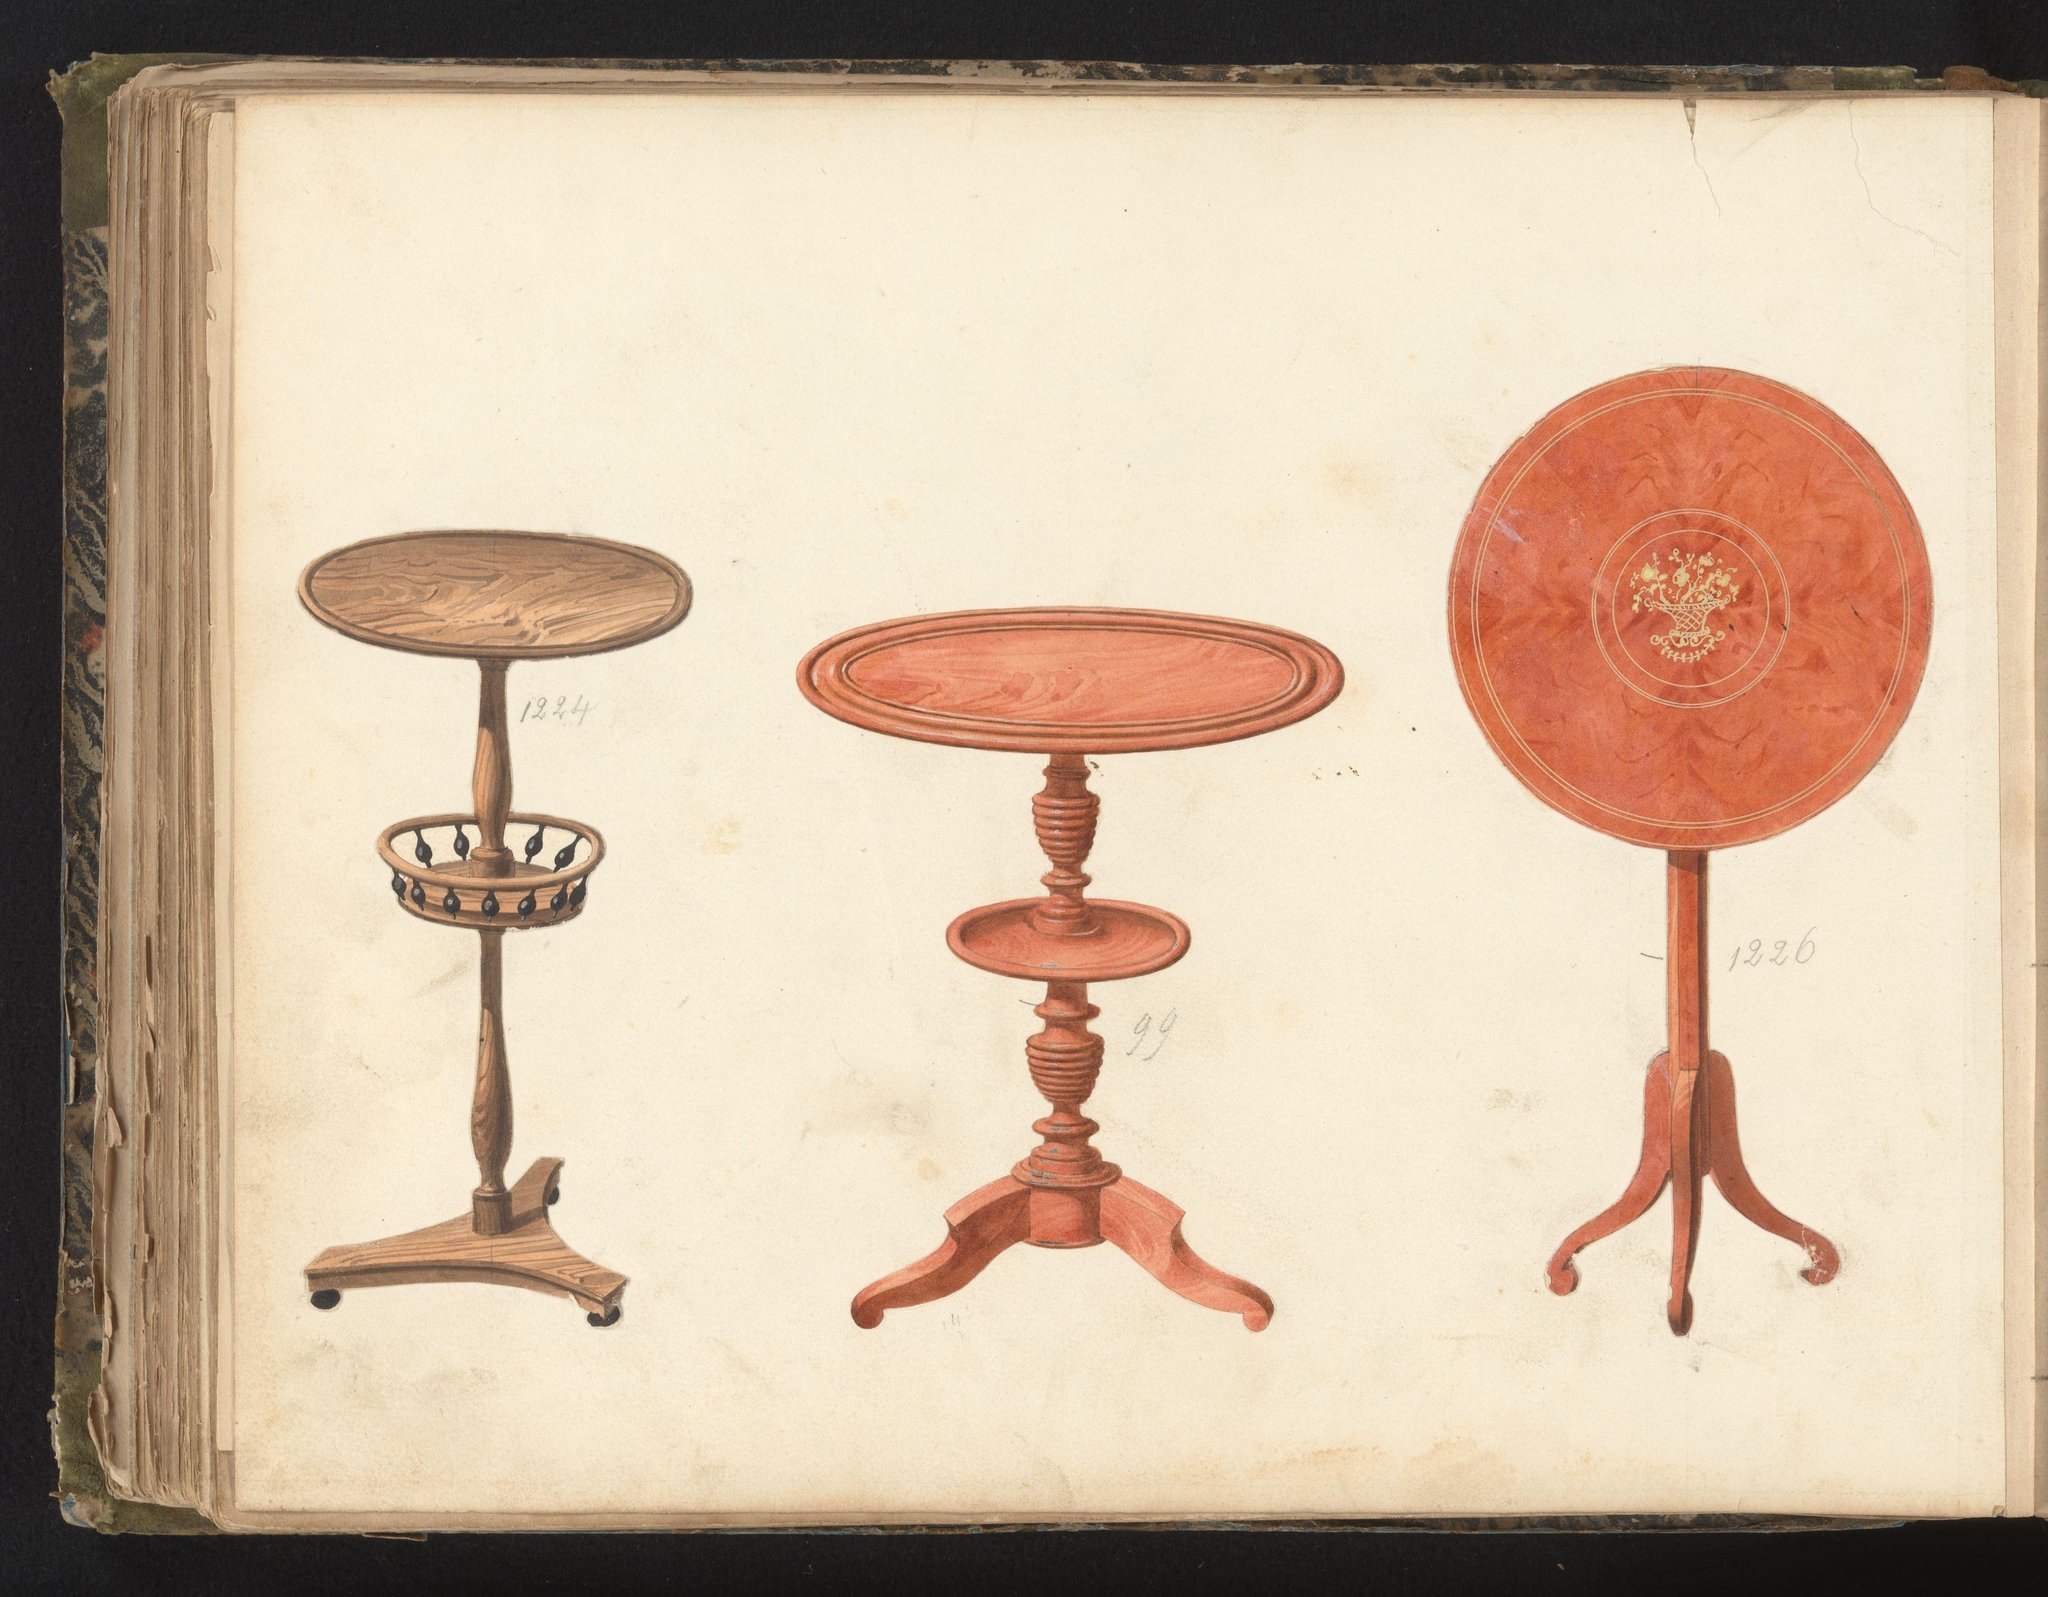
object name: drawing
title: Drie ontwerpen voor gueridons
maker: Anonymous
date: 1825-1839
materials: ink, paper, pencil, watercolor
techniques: brush, pen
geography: paris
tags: table (+ wood and other phytogenic material)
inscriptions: inscription: ‘1226 Gueridon ord[inair]re acajou 20 24 27 30p* la même plaqués dessons coute enplaquet uj. 1224 Gueridon tourne à corbeille en noyer livrés 10* ‘’…’’ vernis la même acajou 13* 99 Gueridon acajou massif à corbeille 20p* la même a corbeille colonne feaux tors.’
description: Drie ontwerpen voor gueridons (bijzettafels), twee van mahoniehout en één van notenhout. Het blad op de achterzijde genummerd: 46, het tegenoverliggende blad met informatie over de afgebeelde meubelen genummerd: 46 bis. Onderdeel van een album met 80 bladen met tekeningen en een prent van gefineerde en gelakte meubelen, alsmede zitmeubelen.